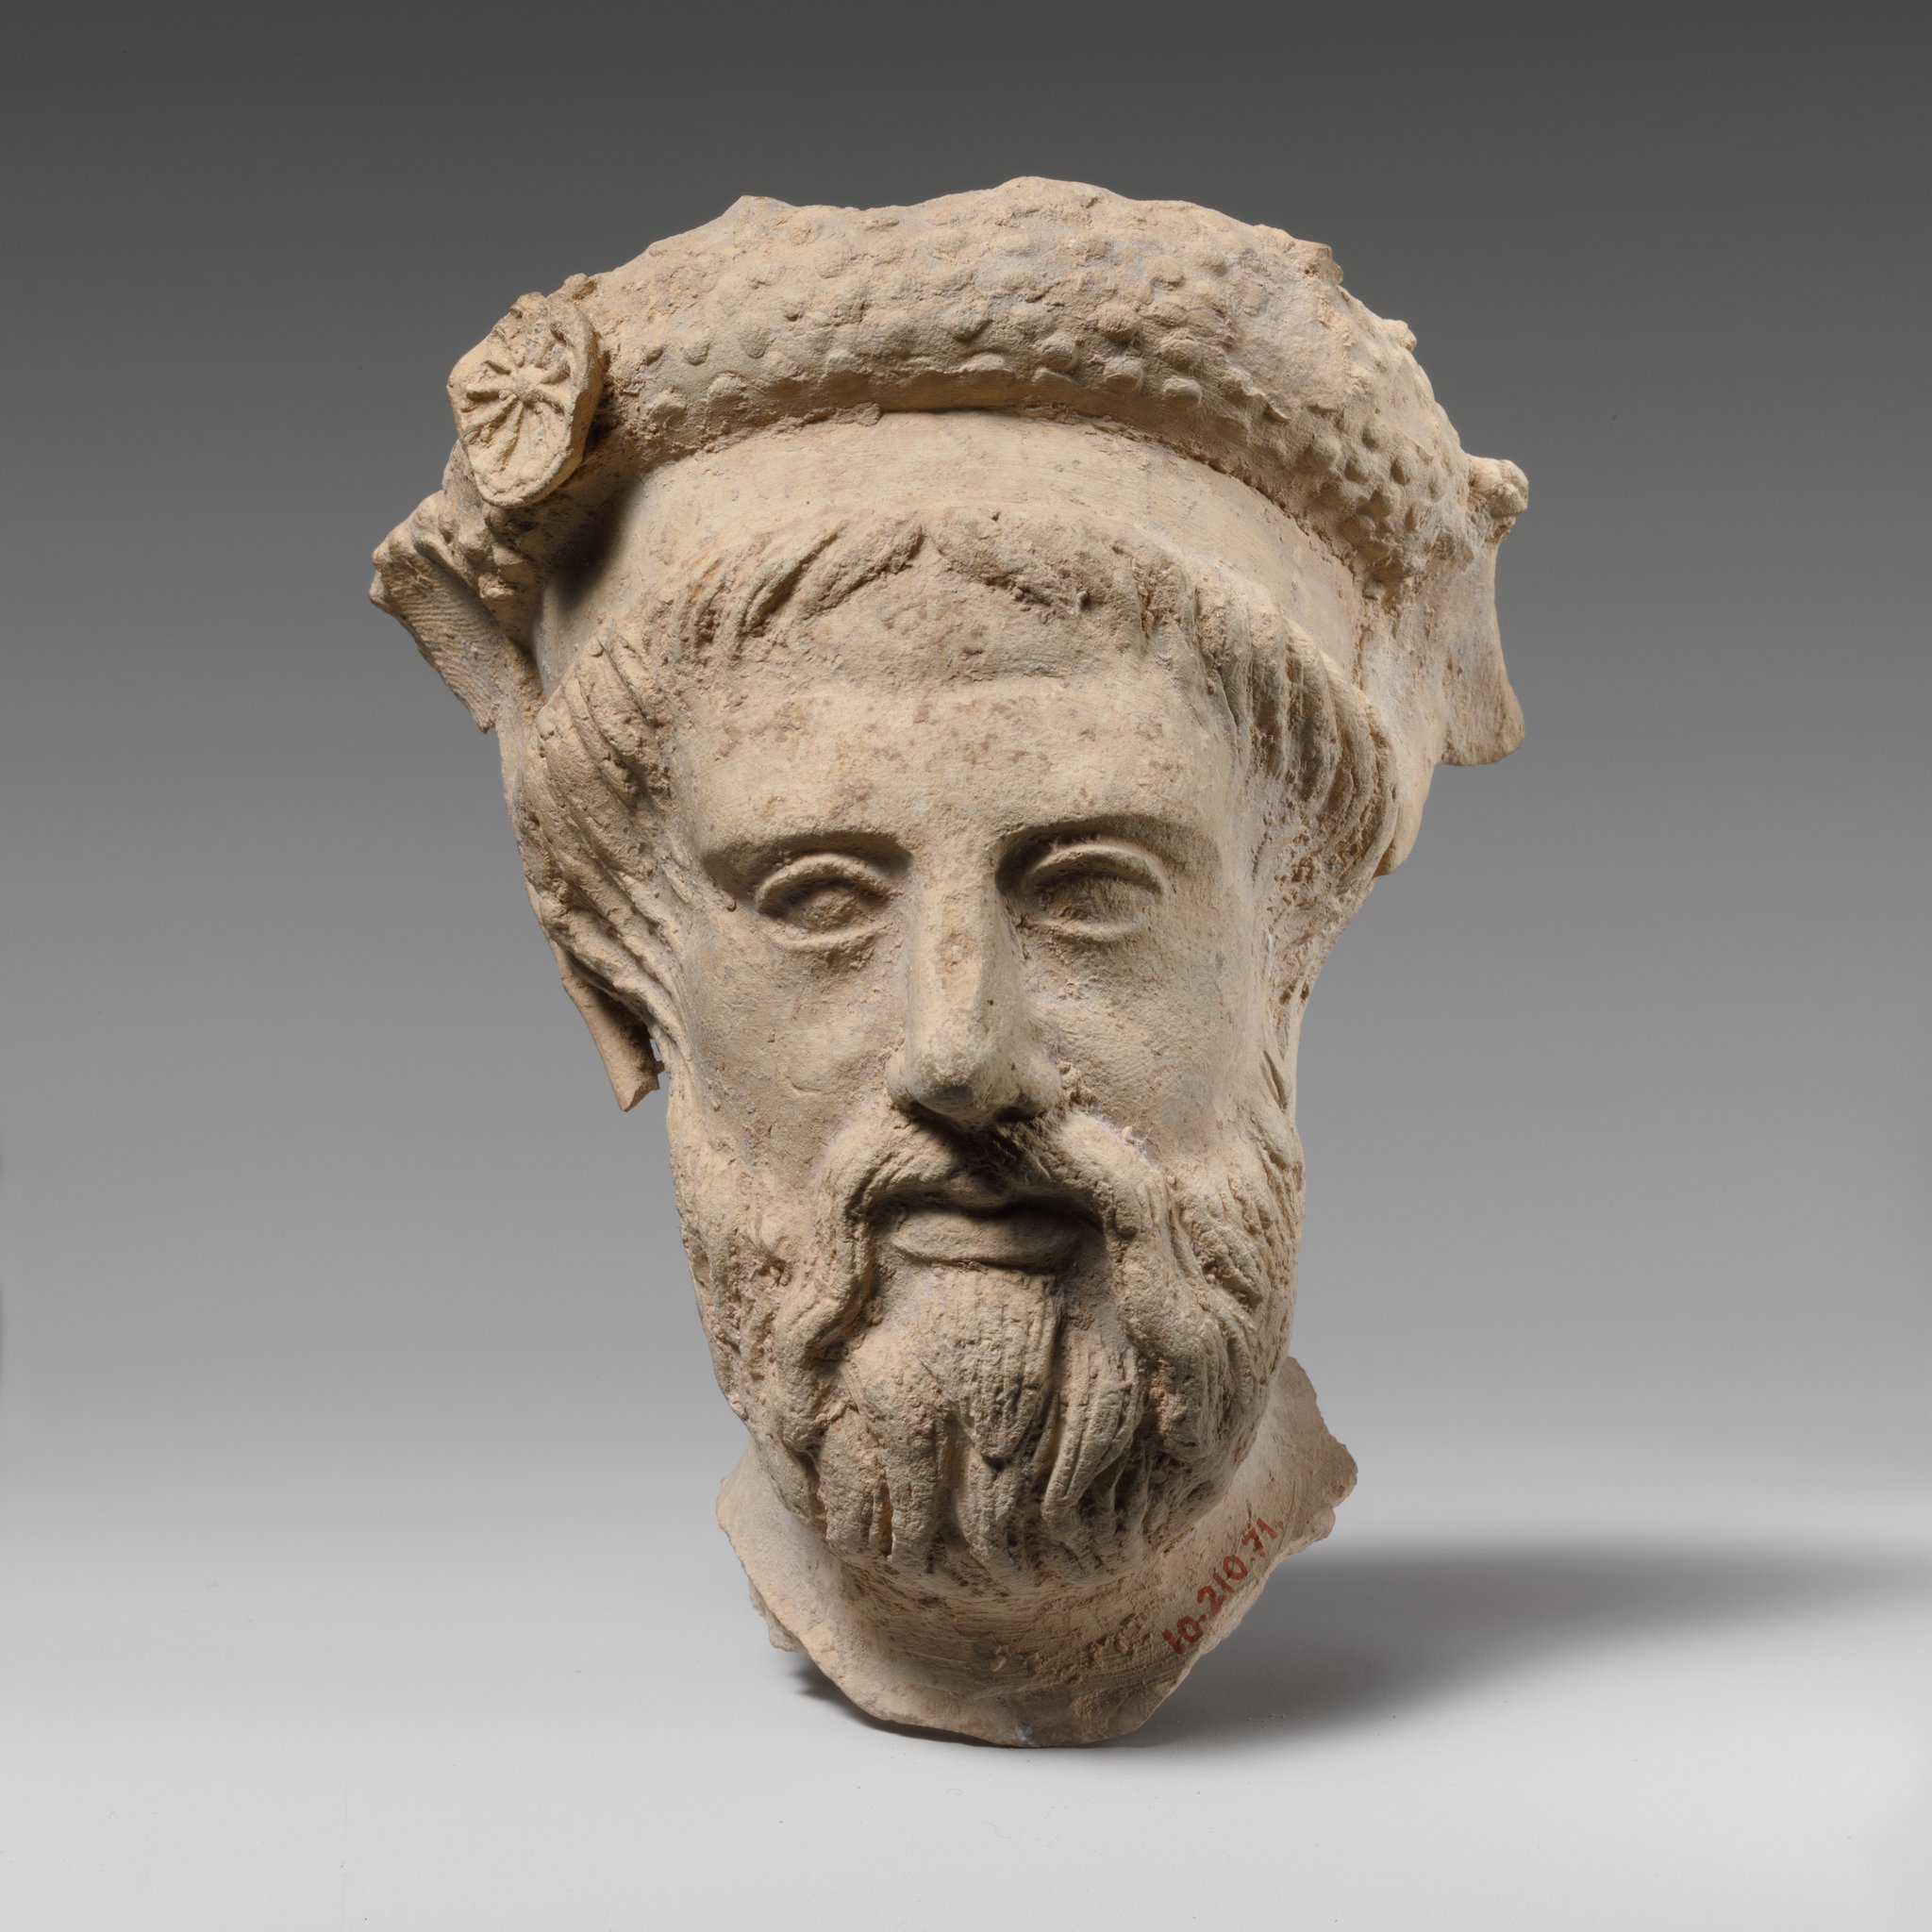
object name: head of dionysos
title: Terracotta head of a bearded man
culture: greek, south italian, tarentine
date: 400-368 BCE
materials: terracotta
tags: heads,men